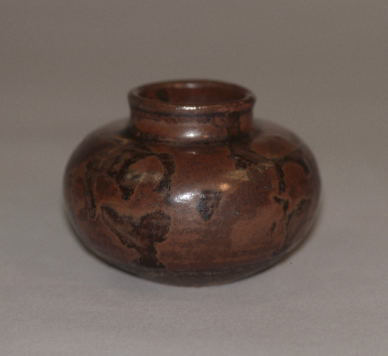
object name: tea jar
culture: japanese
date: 1701-1800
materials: clay, glaze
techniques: overglaze